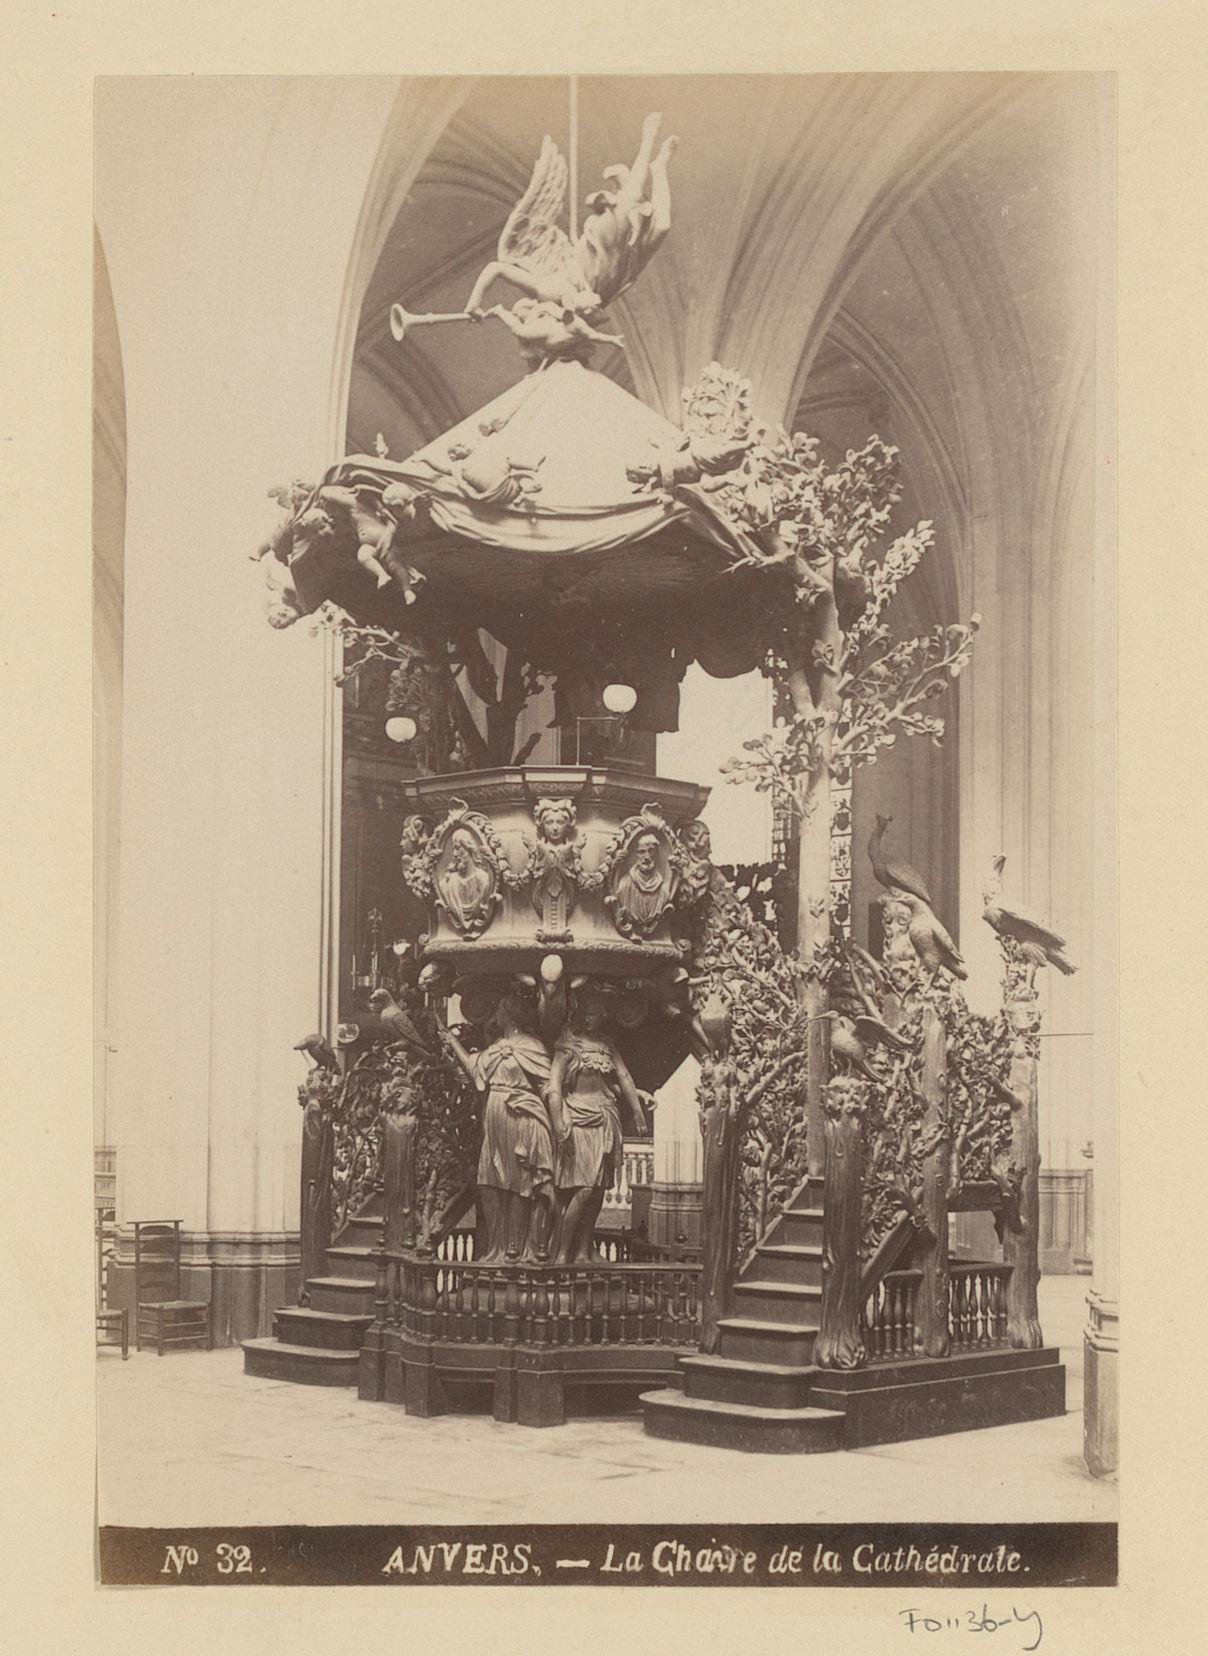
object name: photograph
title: Preekstoel van de Onze-Lieve-Vrouwekathedraal in Antwerpen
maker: gustave hermans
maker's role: publisher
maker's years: 1856-1934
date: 1870-1892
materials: photographic support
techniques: albumen print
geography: antwerp cathedral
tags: piece of sculpture, reproduction of a piece of sculpture (+ sculpture), pulpit, ambo, chancel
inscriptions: number: ‘32’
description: Onderdeel van Fotoalbum met opnames van bezienswaardigheden in België, Duitsland en Noorwegen.